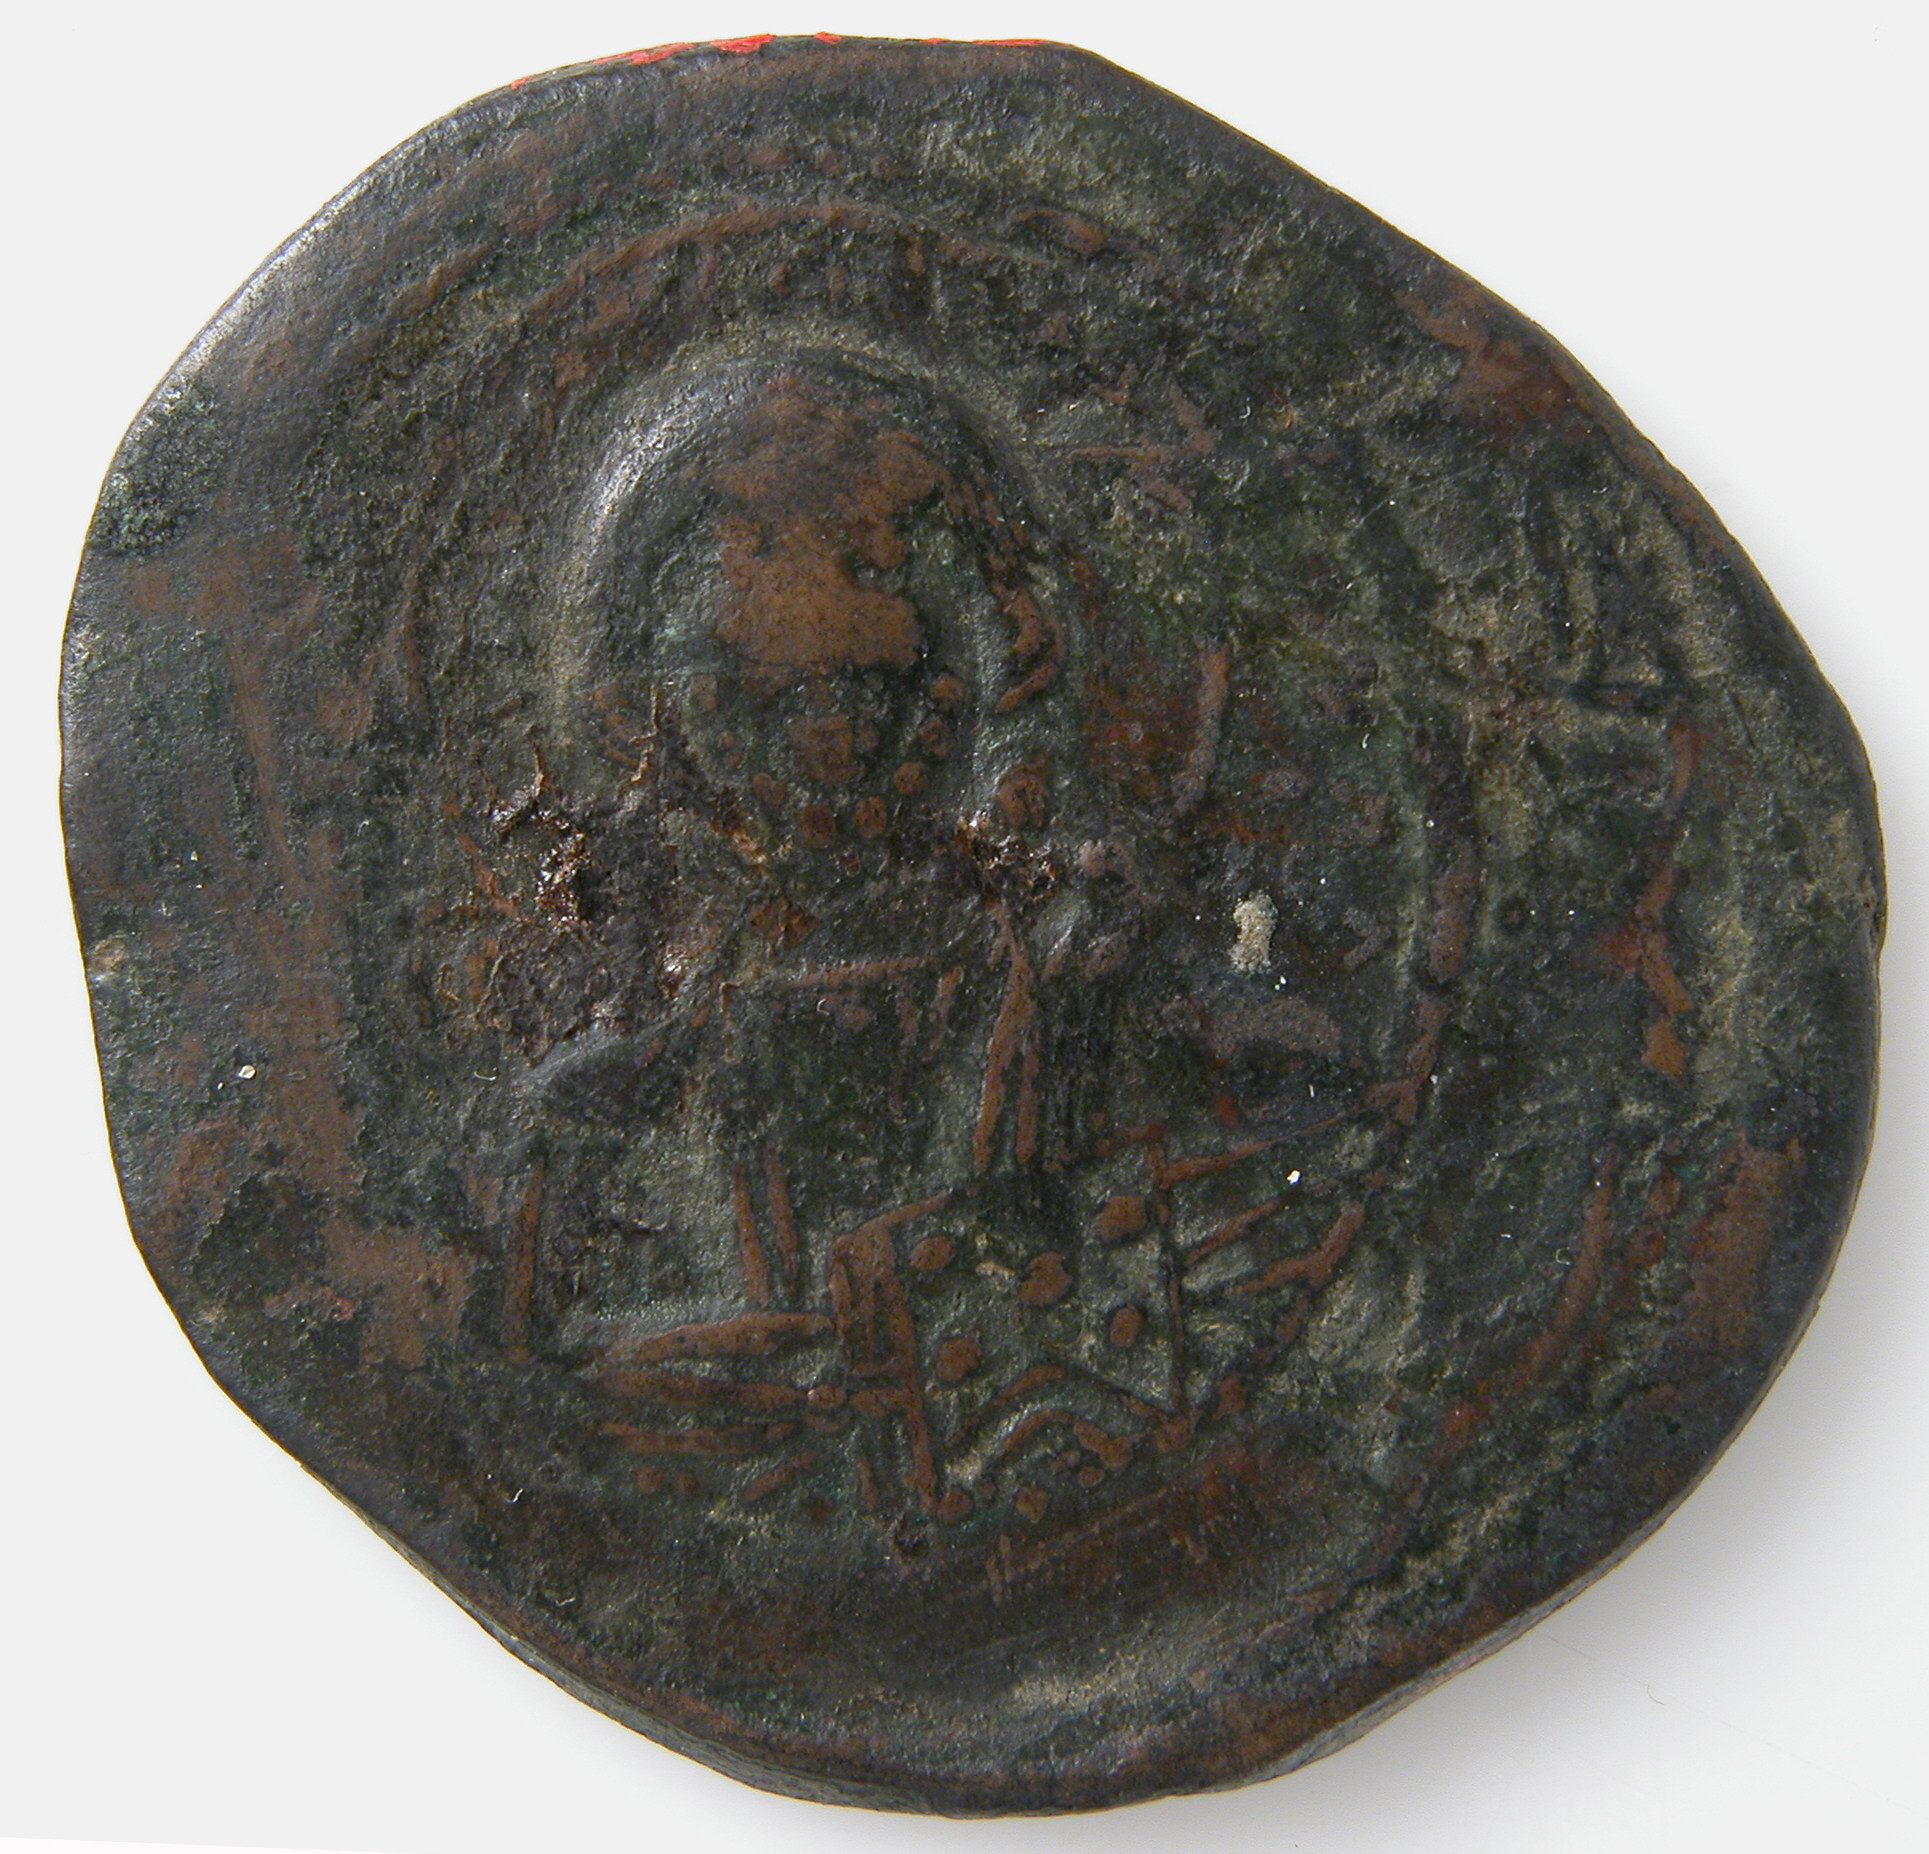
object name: coin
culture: byzantine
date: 1001-1100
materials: copper alloy